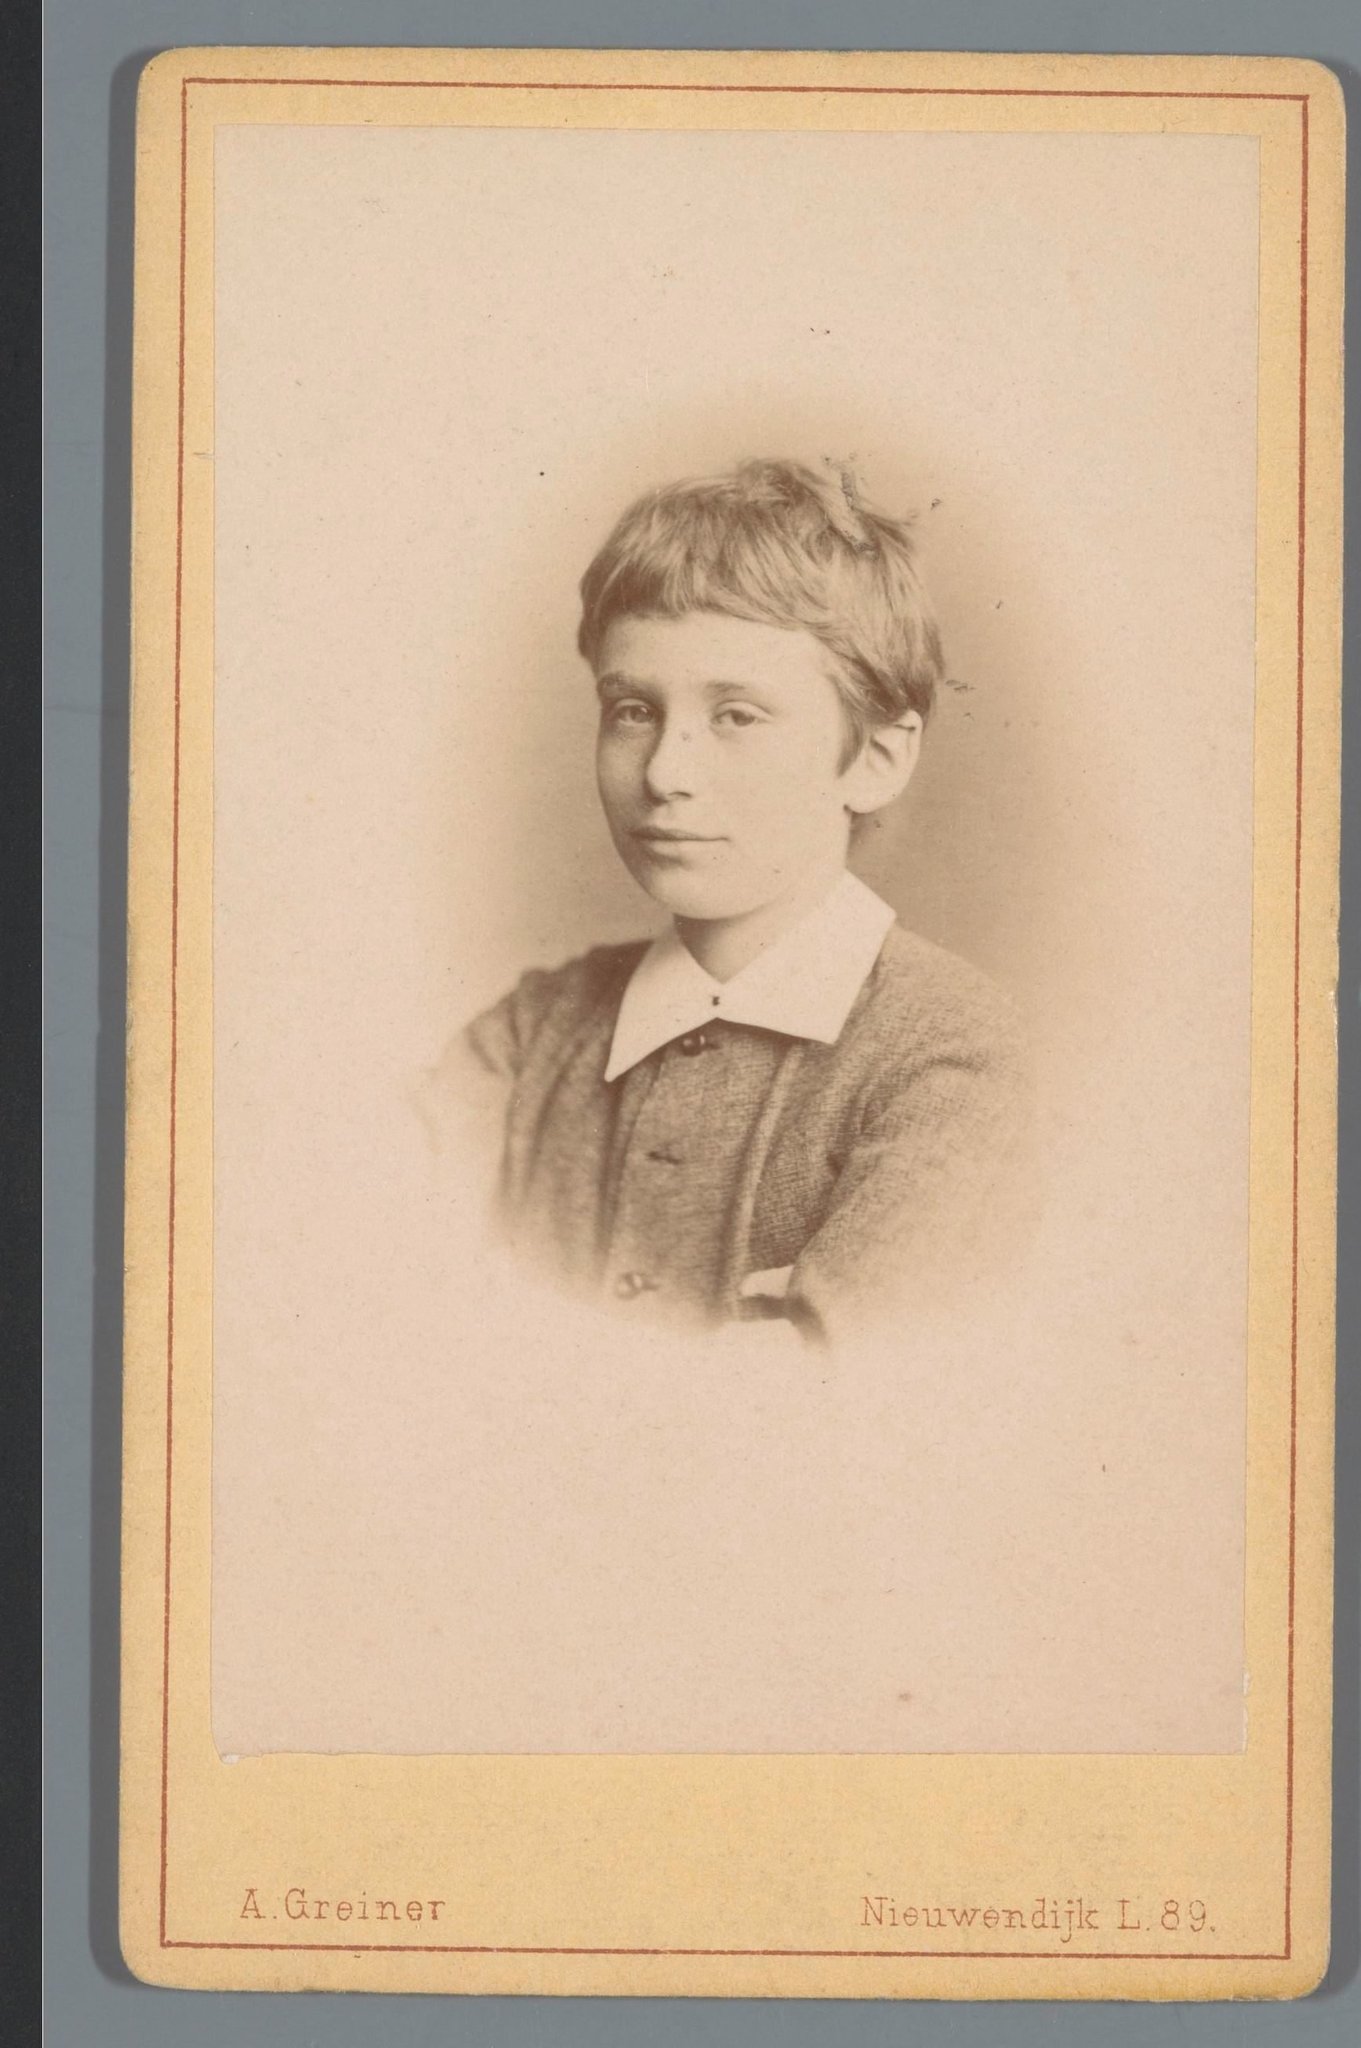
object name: photograph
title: Portret van een onbekende jongen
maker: albert greiner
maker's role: fotograaf, fotostudio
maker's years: 1833-1890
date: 1874-1889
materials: cardboard, paper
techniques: albumen print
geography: amsterdam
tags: boy (child between toddler and youth), historical persons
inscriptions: inscription: ‘AG/ A. GREINER/ Photograf/ AMSTERDAM/ NIEUWENDIJK L. 89.’